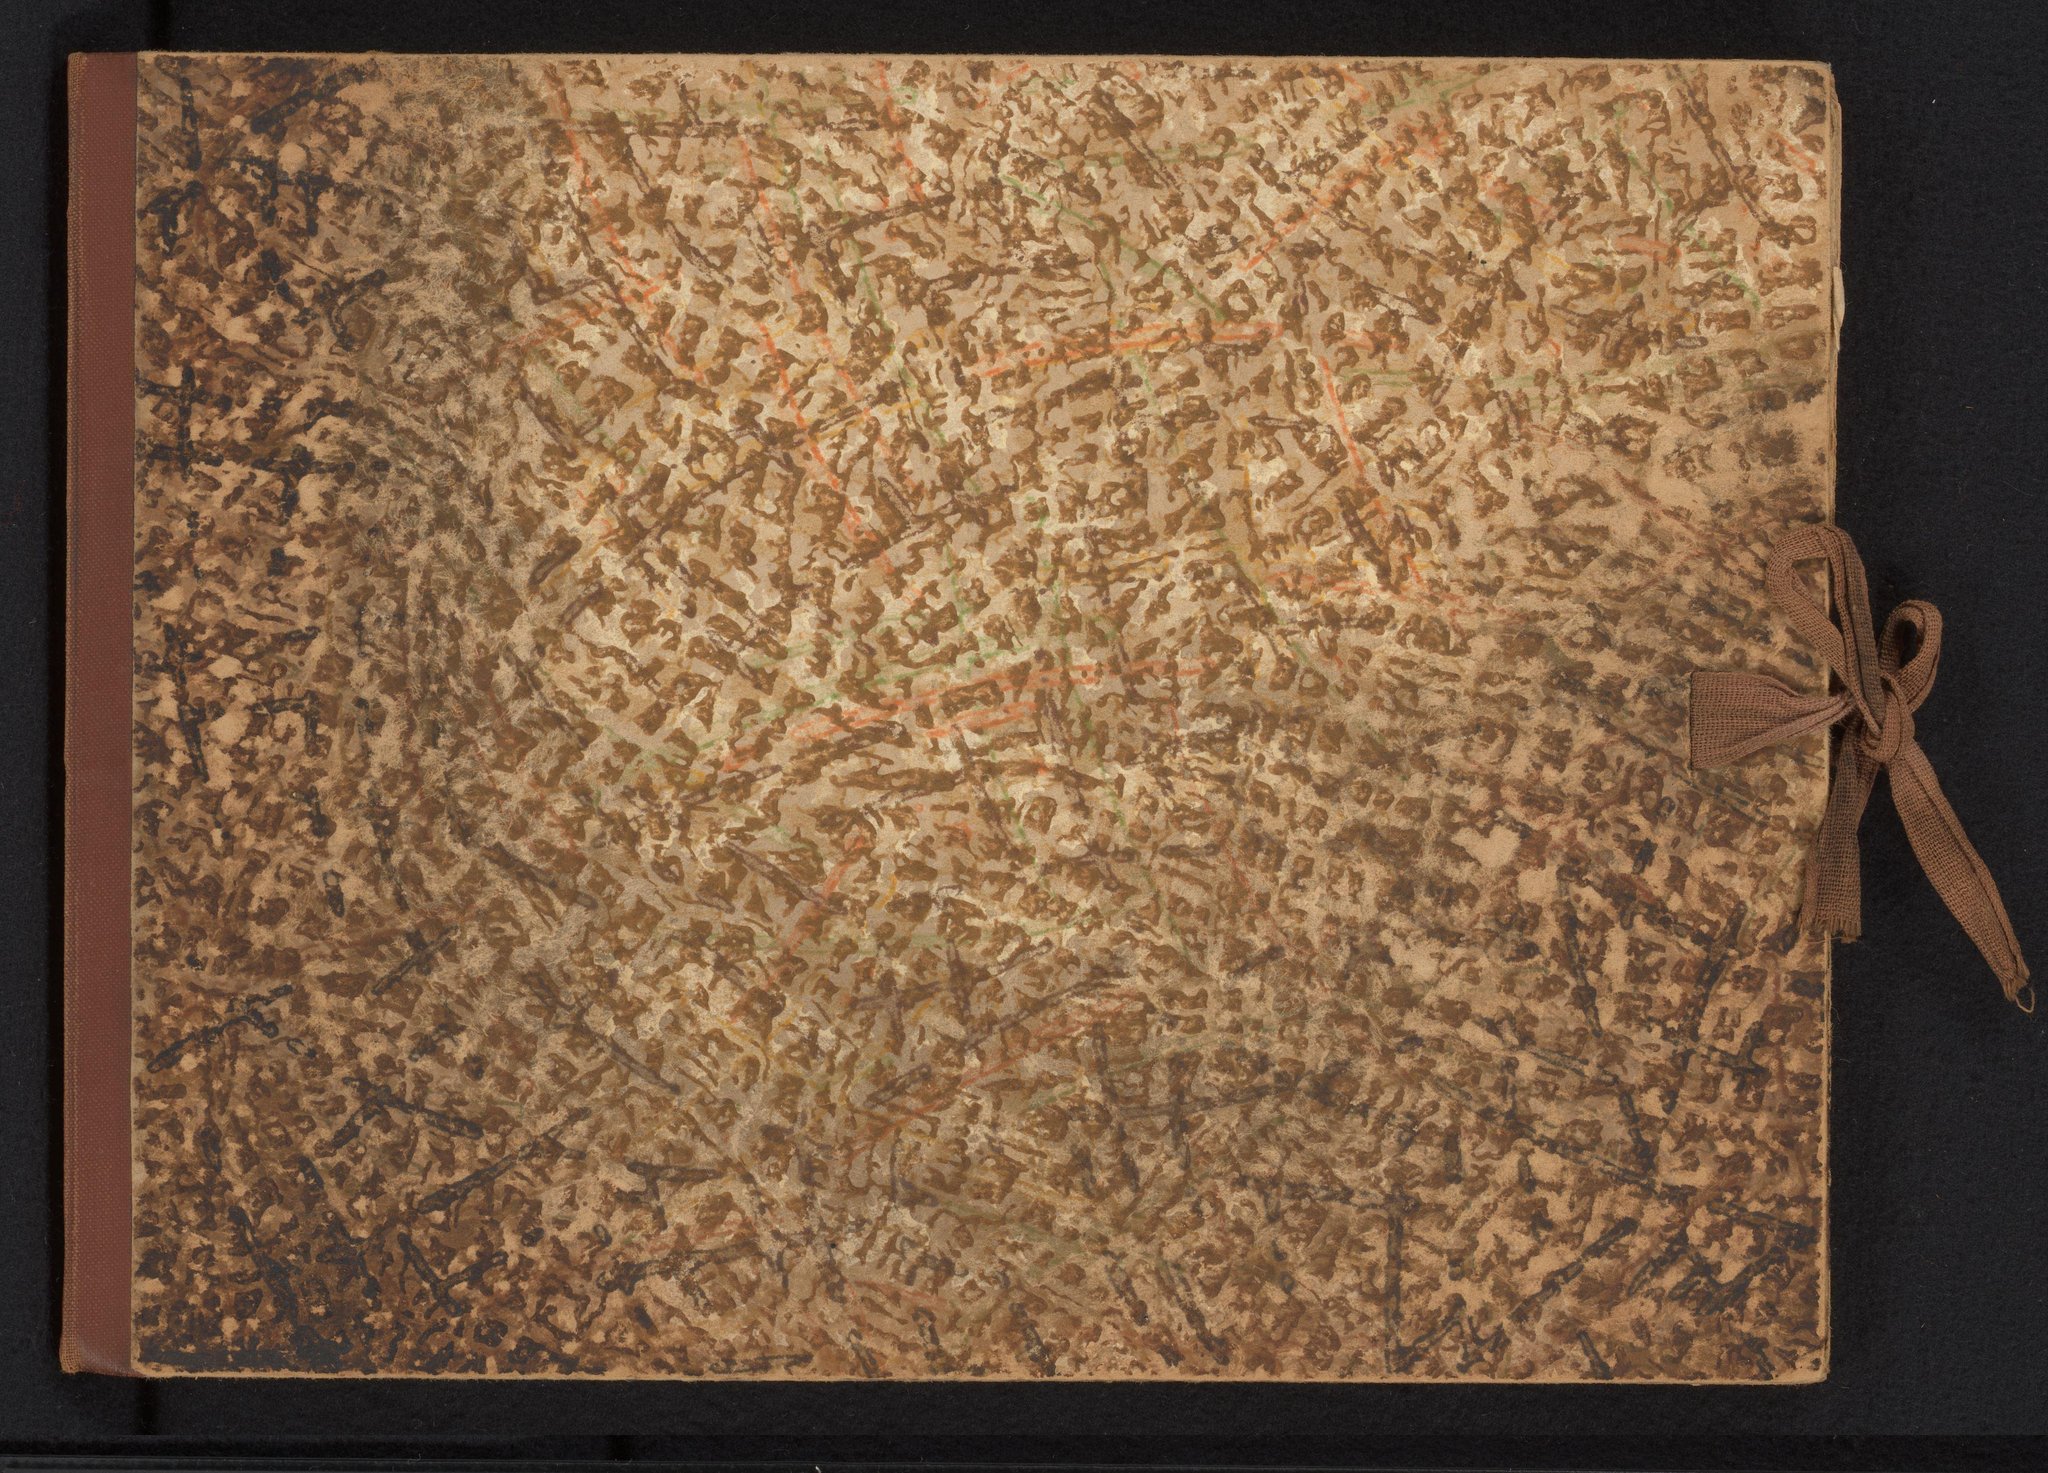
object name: book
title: Illustrations of Japanese life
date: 1896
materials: cardboard, linen, paper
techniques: collotype process, printing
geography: tokyo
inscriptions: annotation: ‘[...] Japan [...]’